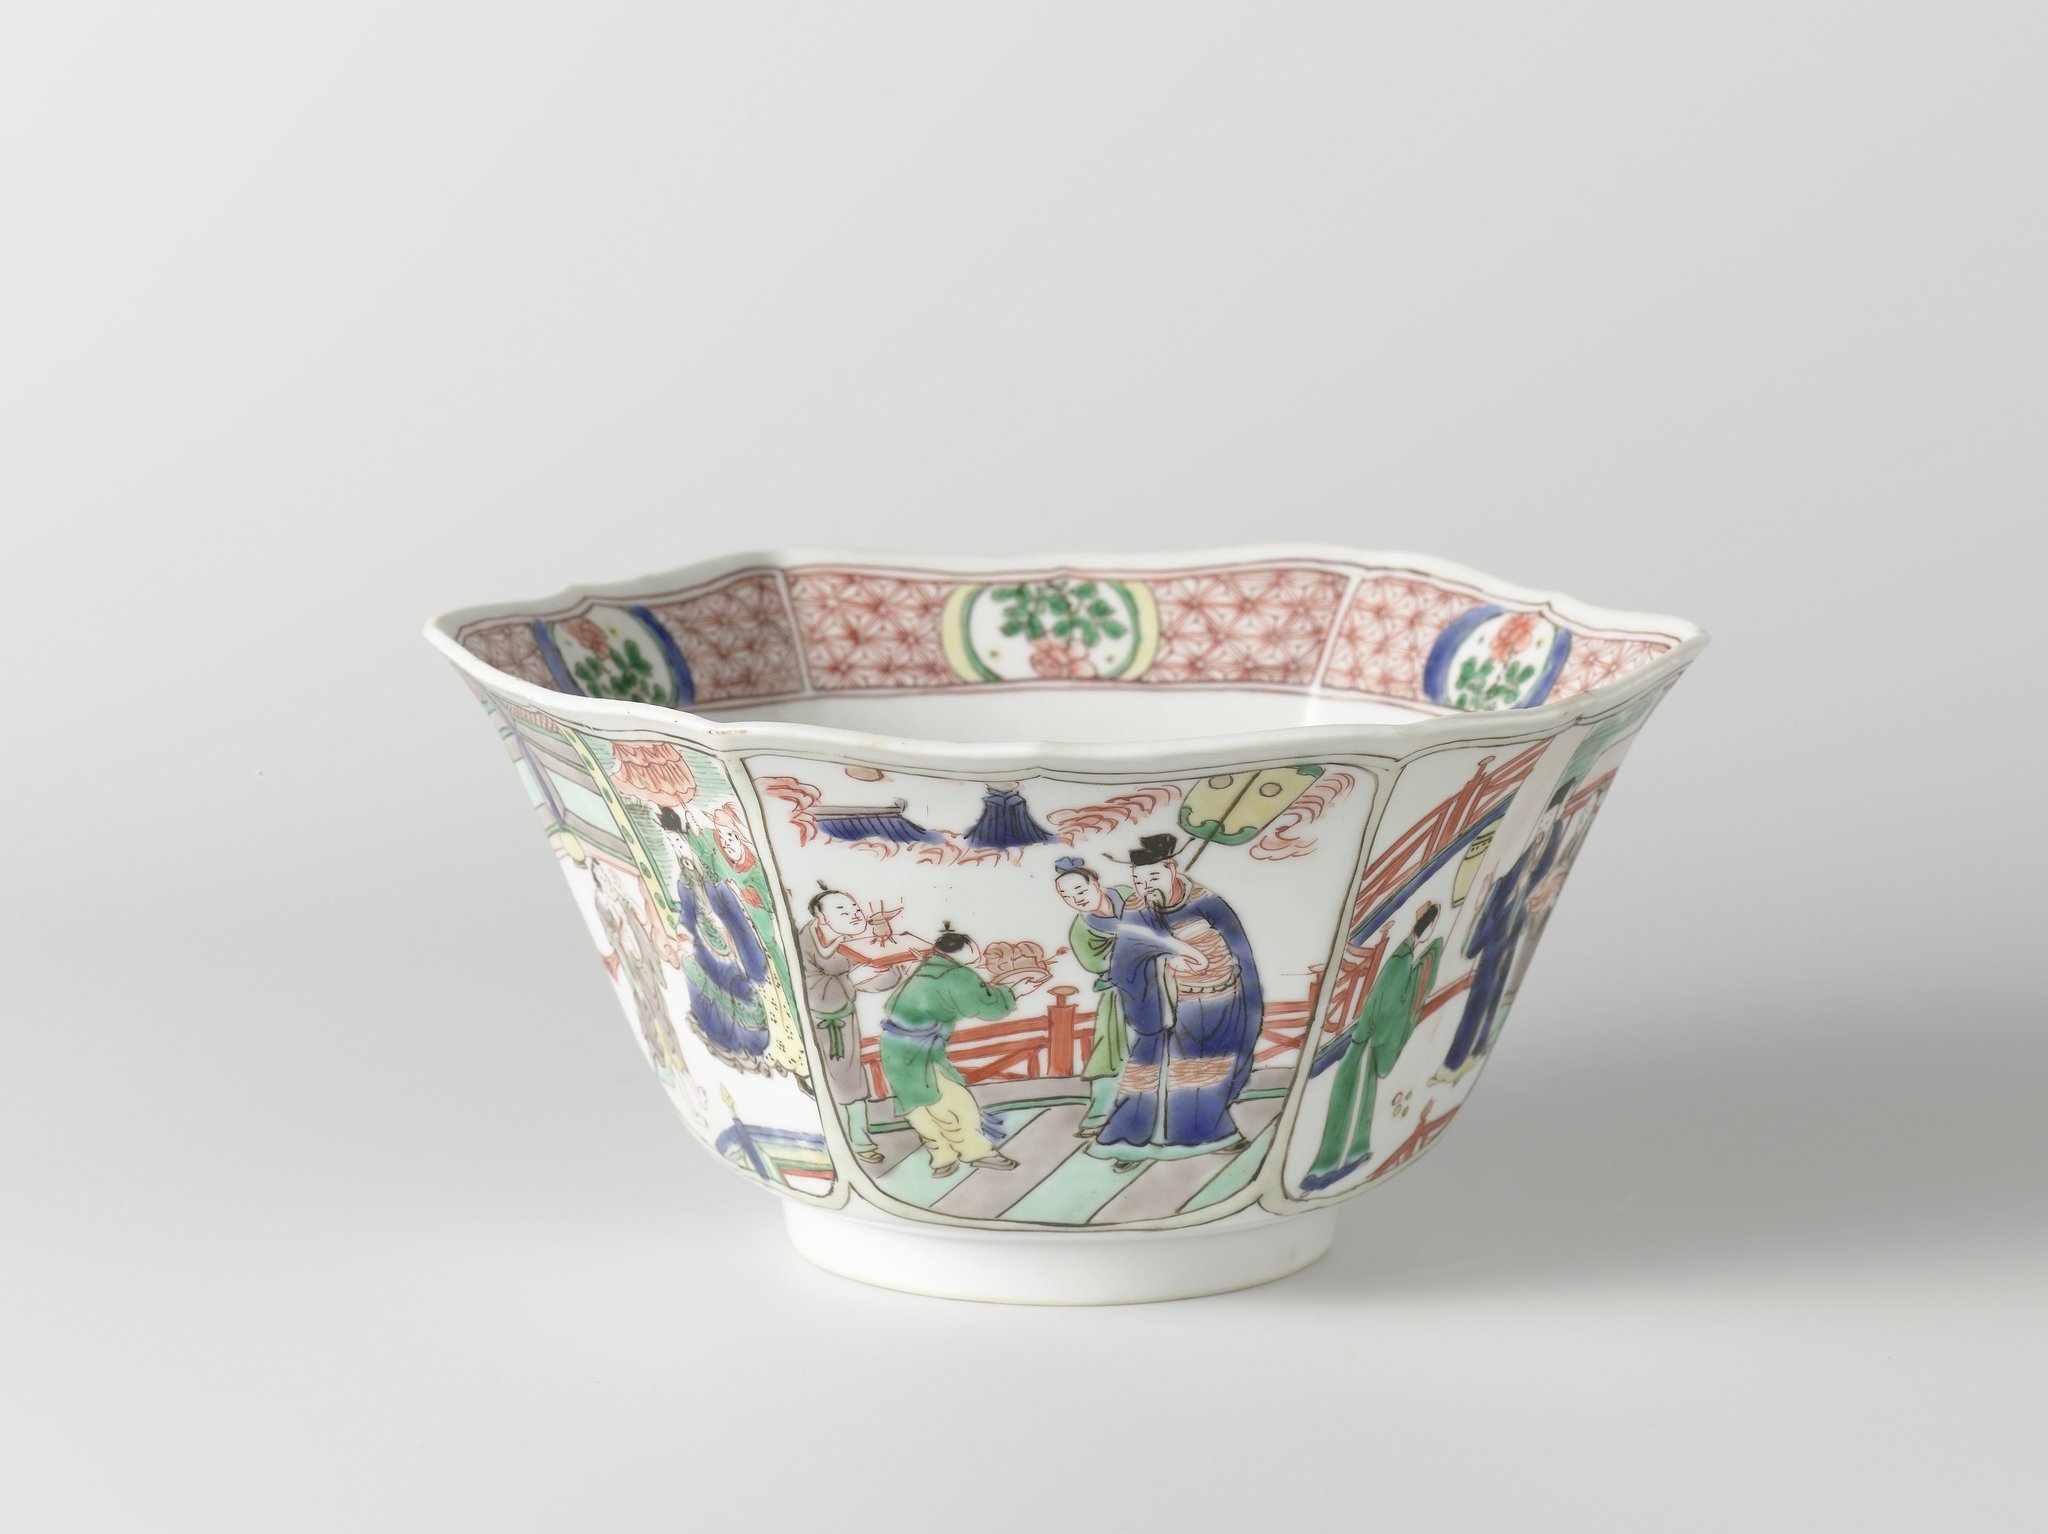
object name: bowl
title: Hexagonal bowl with narrative scenes concerning Lü Dongbin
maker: Anonymous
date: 1700-1724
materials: cobalt, glaze, gold, paint, porcelain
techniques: firing, gilding, turning, vitrification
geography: china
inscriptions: mark: ‘大 明 成 化 年 製’